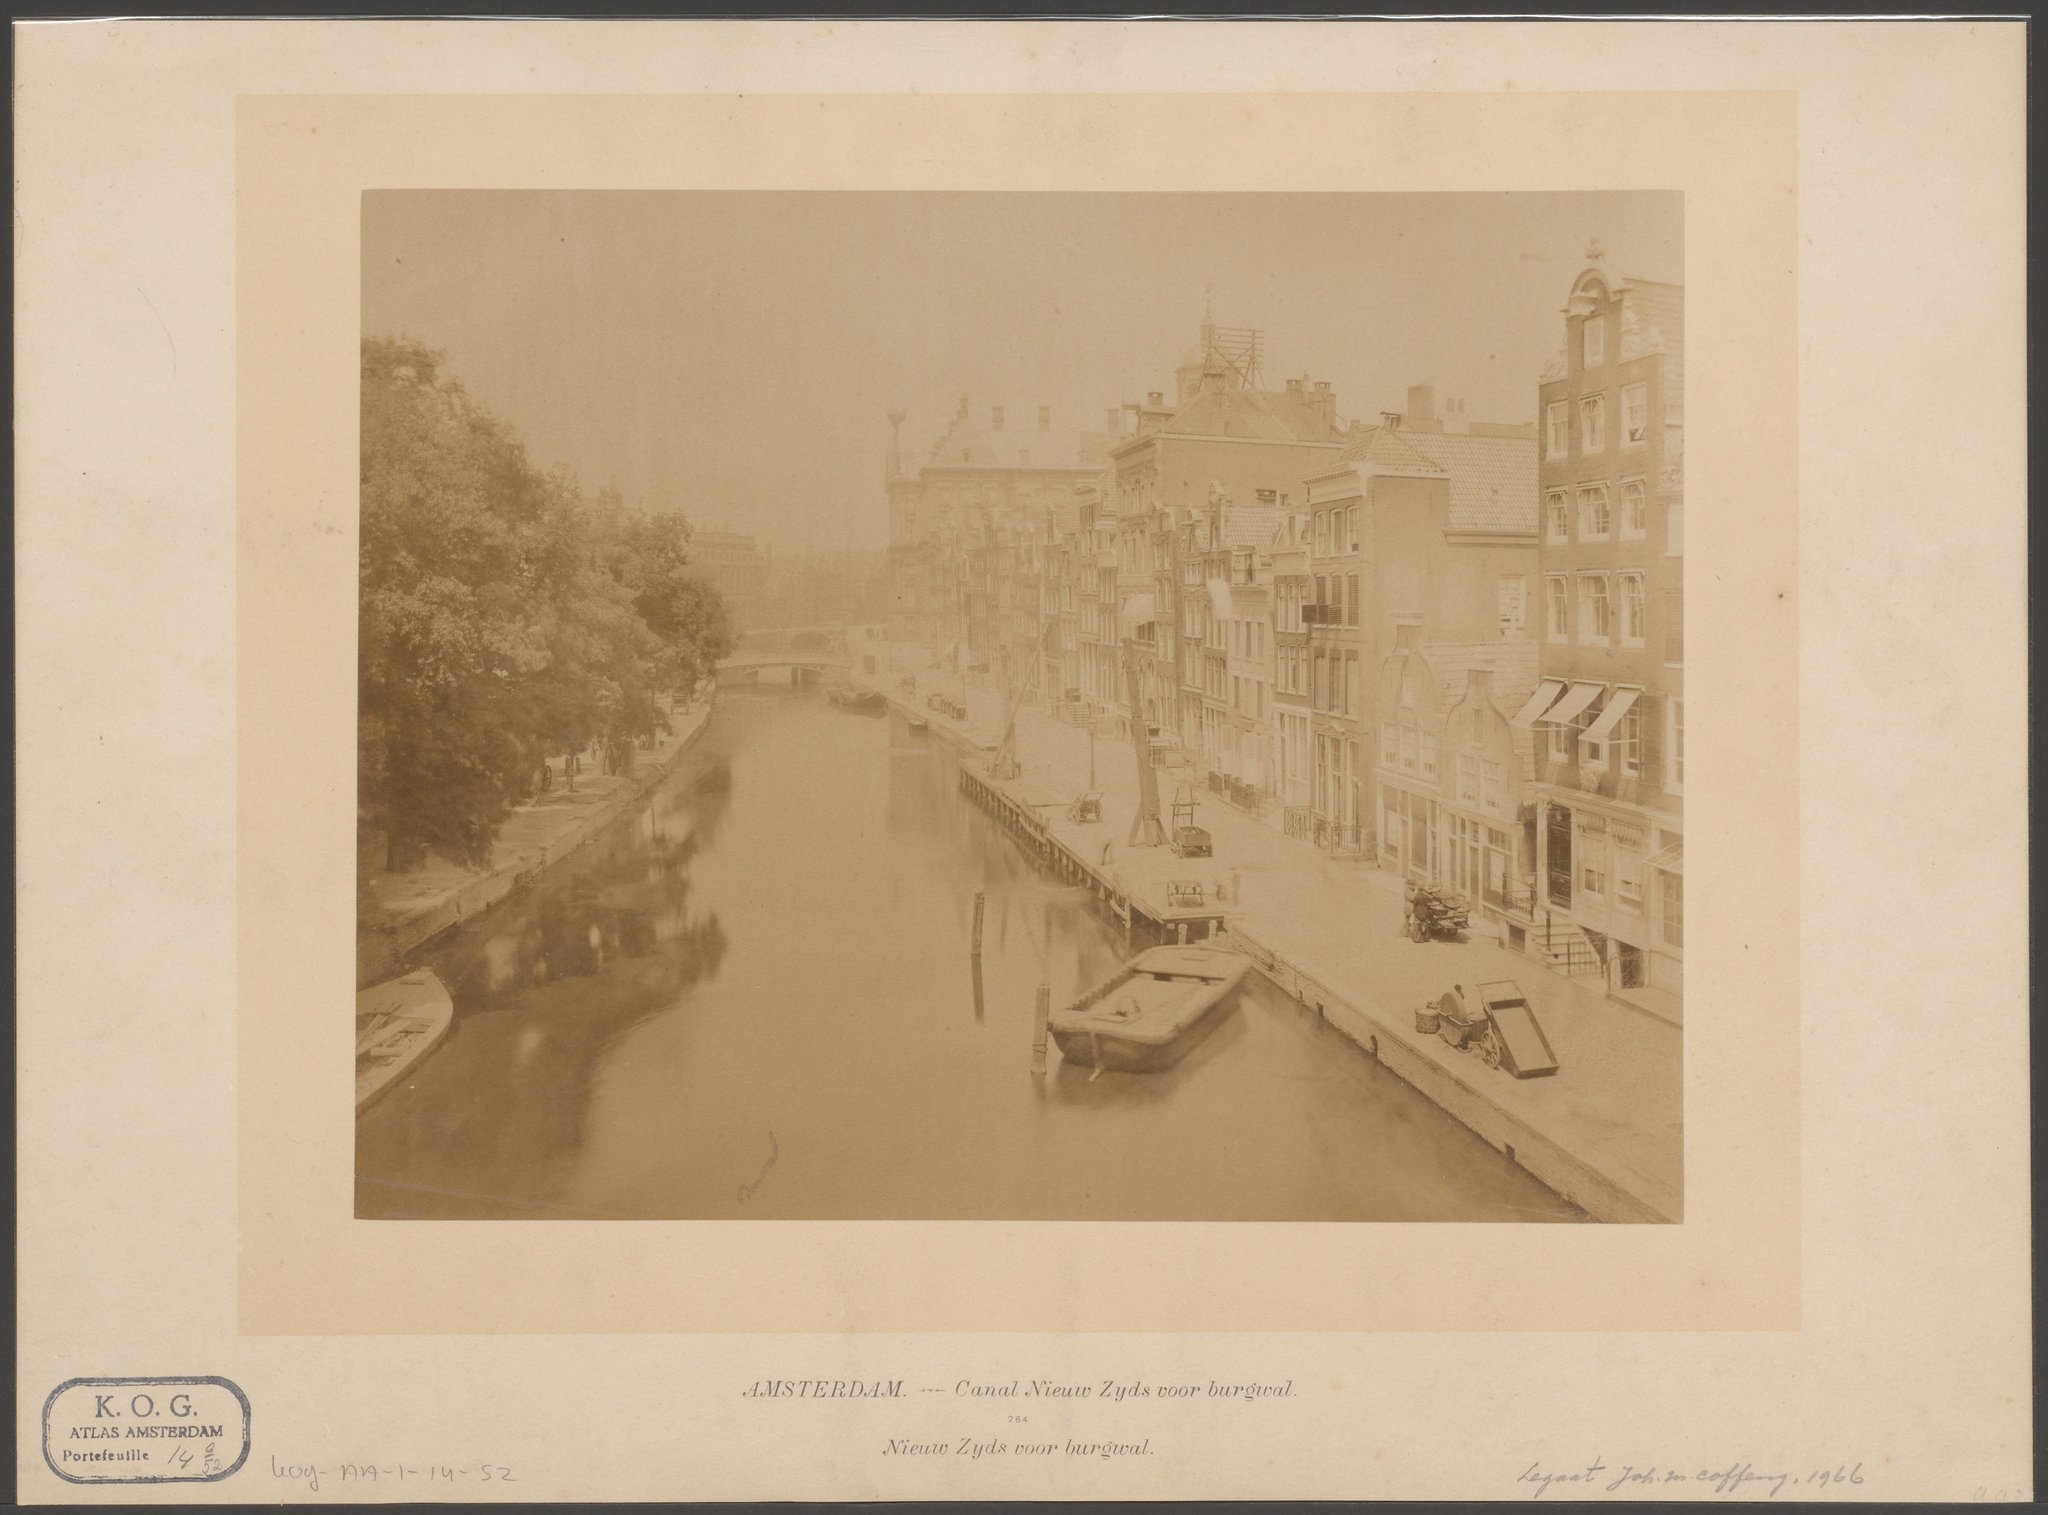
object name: photograph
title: Gezicht op de Nieuwezijds Voorburgwal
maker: Anonymous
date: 1850-1884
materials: cardboard, paper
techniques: albumen print, lithograph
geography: amsterdam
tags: city-view in general; 'veduta', canal, the usual house or row of houses, bridge in city across river, canal, etc., street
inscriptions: inscription: ‘Legaat Joh. M. Coffeng. 1966’, collector's mark: ‘14a 52’ Lugt 1641b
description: Onderwerpsrubriek binnen de Atlas Amsterdam: Verhulststraat (Johannes), Viaducten, Vierwindenstraat, Vinkenbuurt, Vinkenpad, Vinkenstraat, Vischsteeg, Vliegendesteeg, Voetboogstraat, Volewijk, Vondelstraat, Voorburgwal (N.Z.).